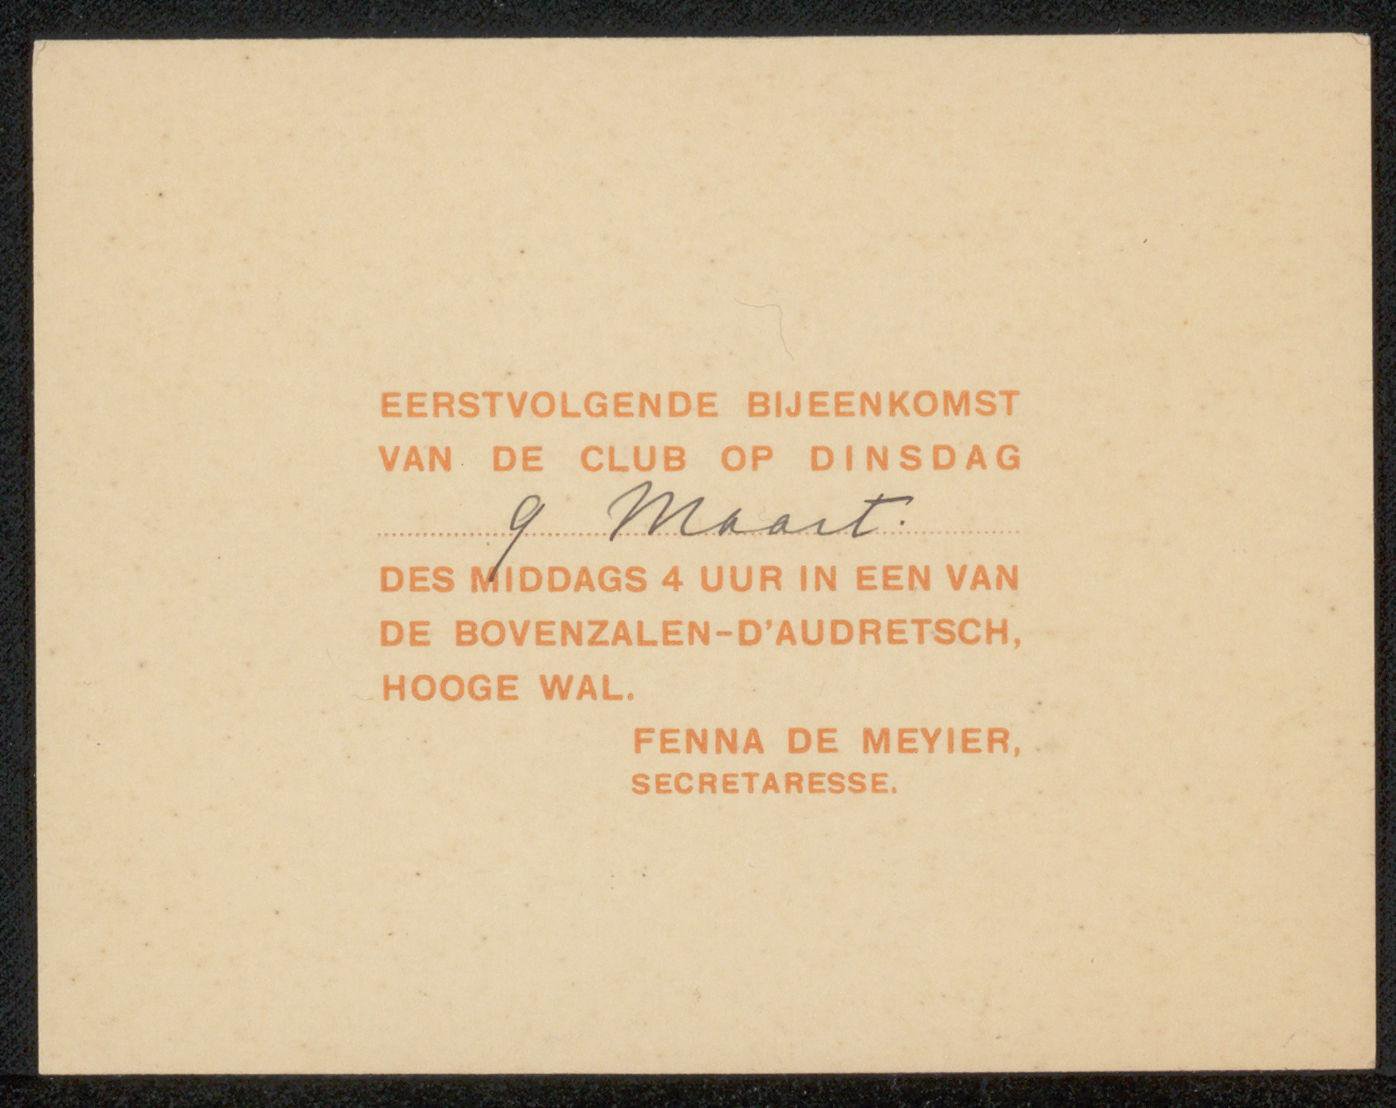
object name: invitation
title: Uitnodiging aan Philip Zilcken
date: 1915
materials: cardboard, ink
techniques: pen, printing, writing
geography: the hague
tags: the hague, painter, draughtsman, philip zilcken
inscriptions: collector's mark: ‘RPK’